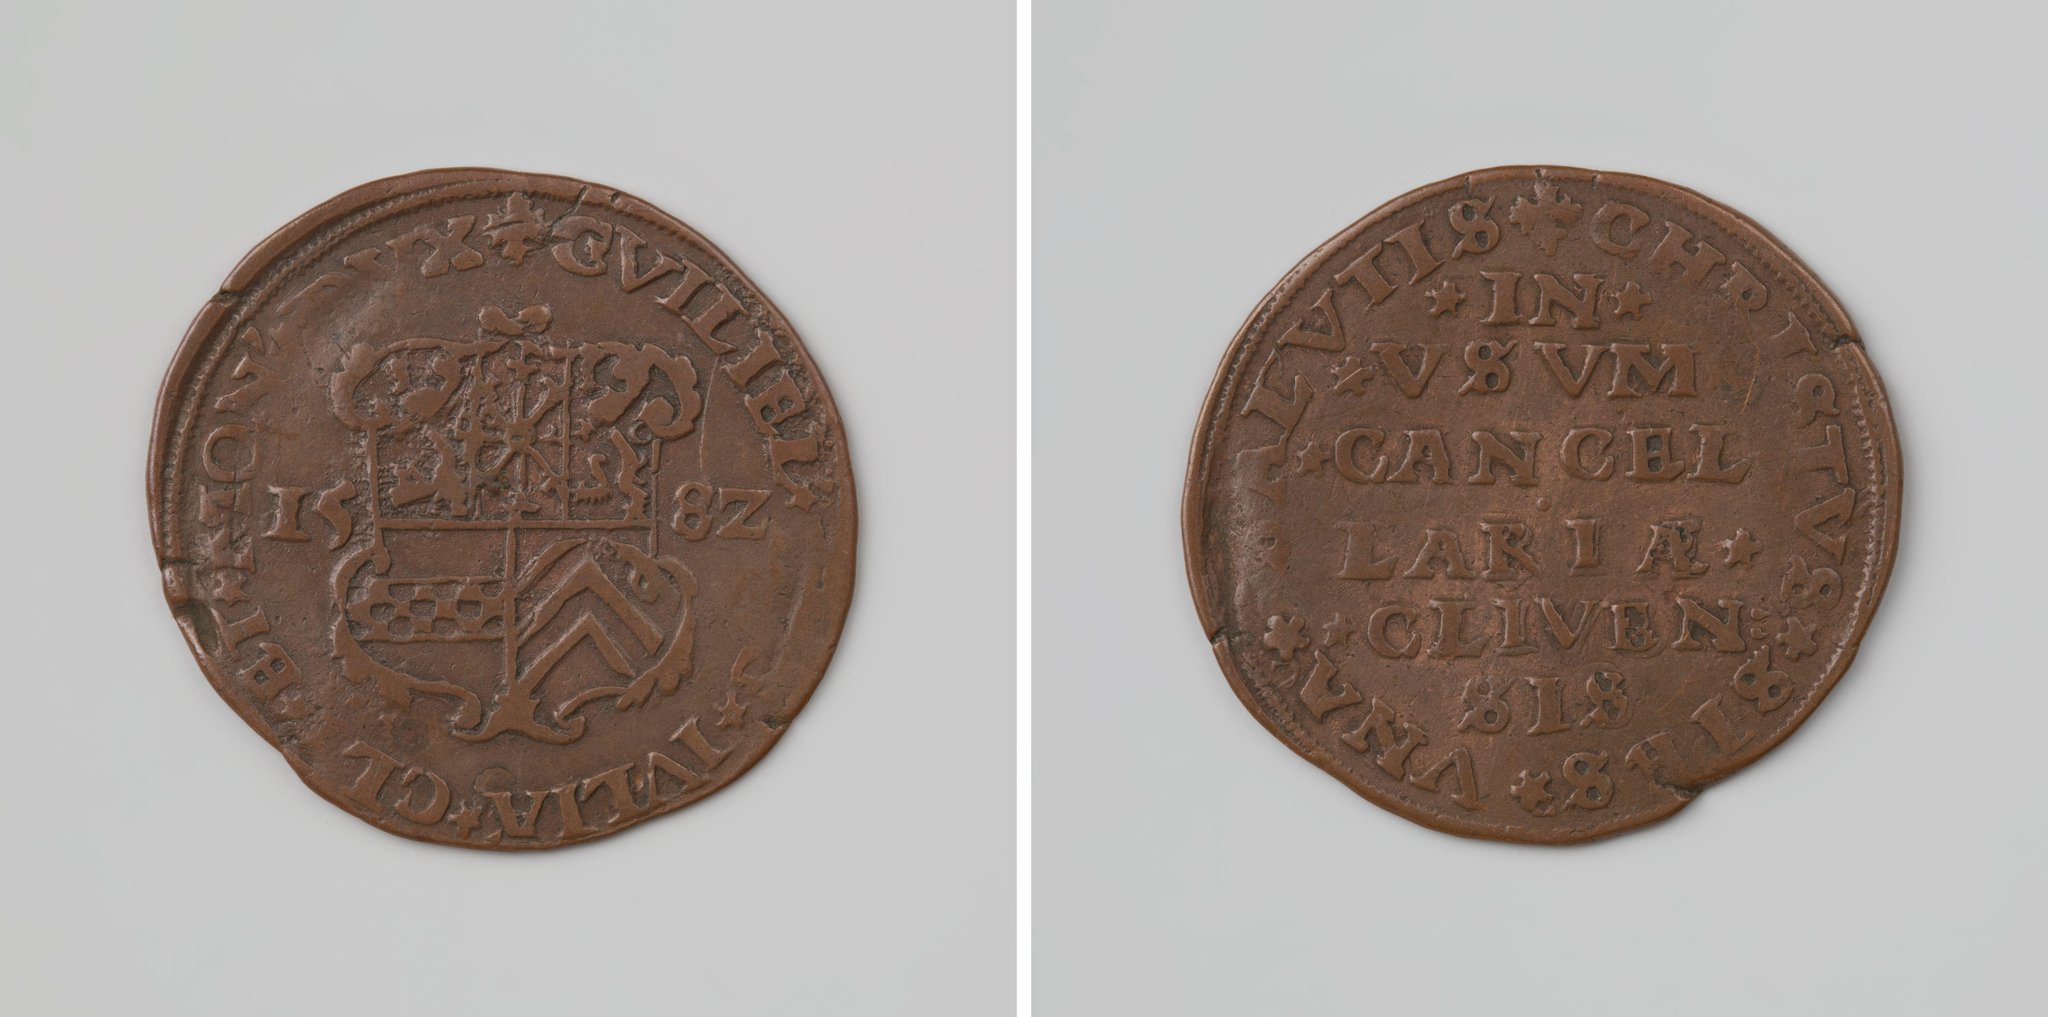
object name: jeton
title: Willem II, hertog van Gulik en Kleef, rekenpenning van de kanselarij van Kleef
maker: Anonymous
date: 1582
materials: copper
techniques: striking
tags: cleves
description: Koperen penning. Voorzijde: wapenschild tussen jaartal binnen omschrift. Keerzijde: opschrift binnen omschrift